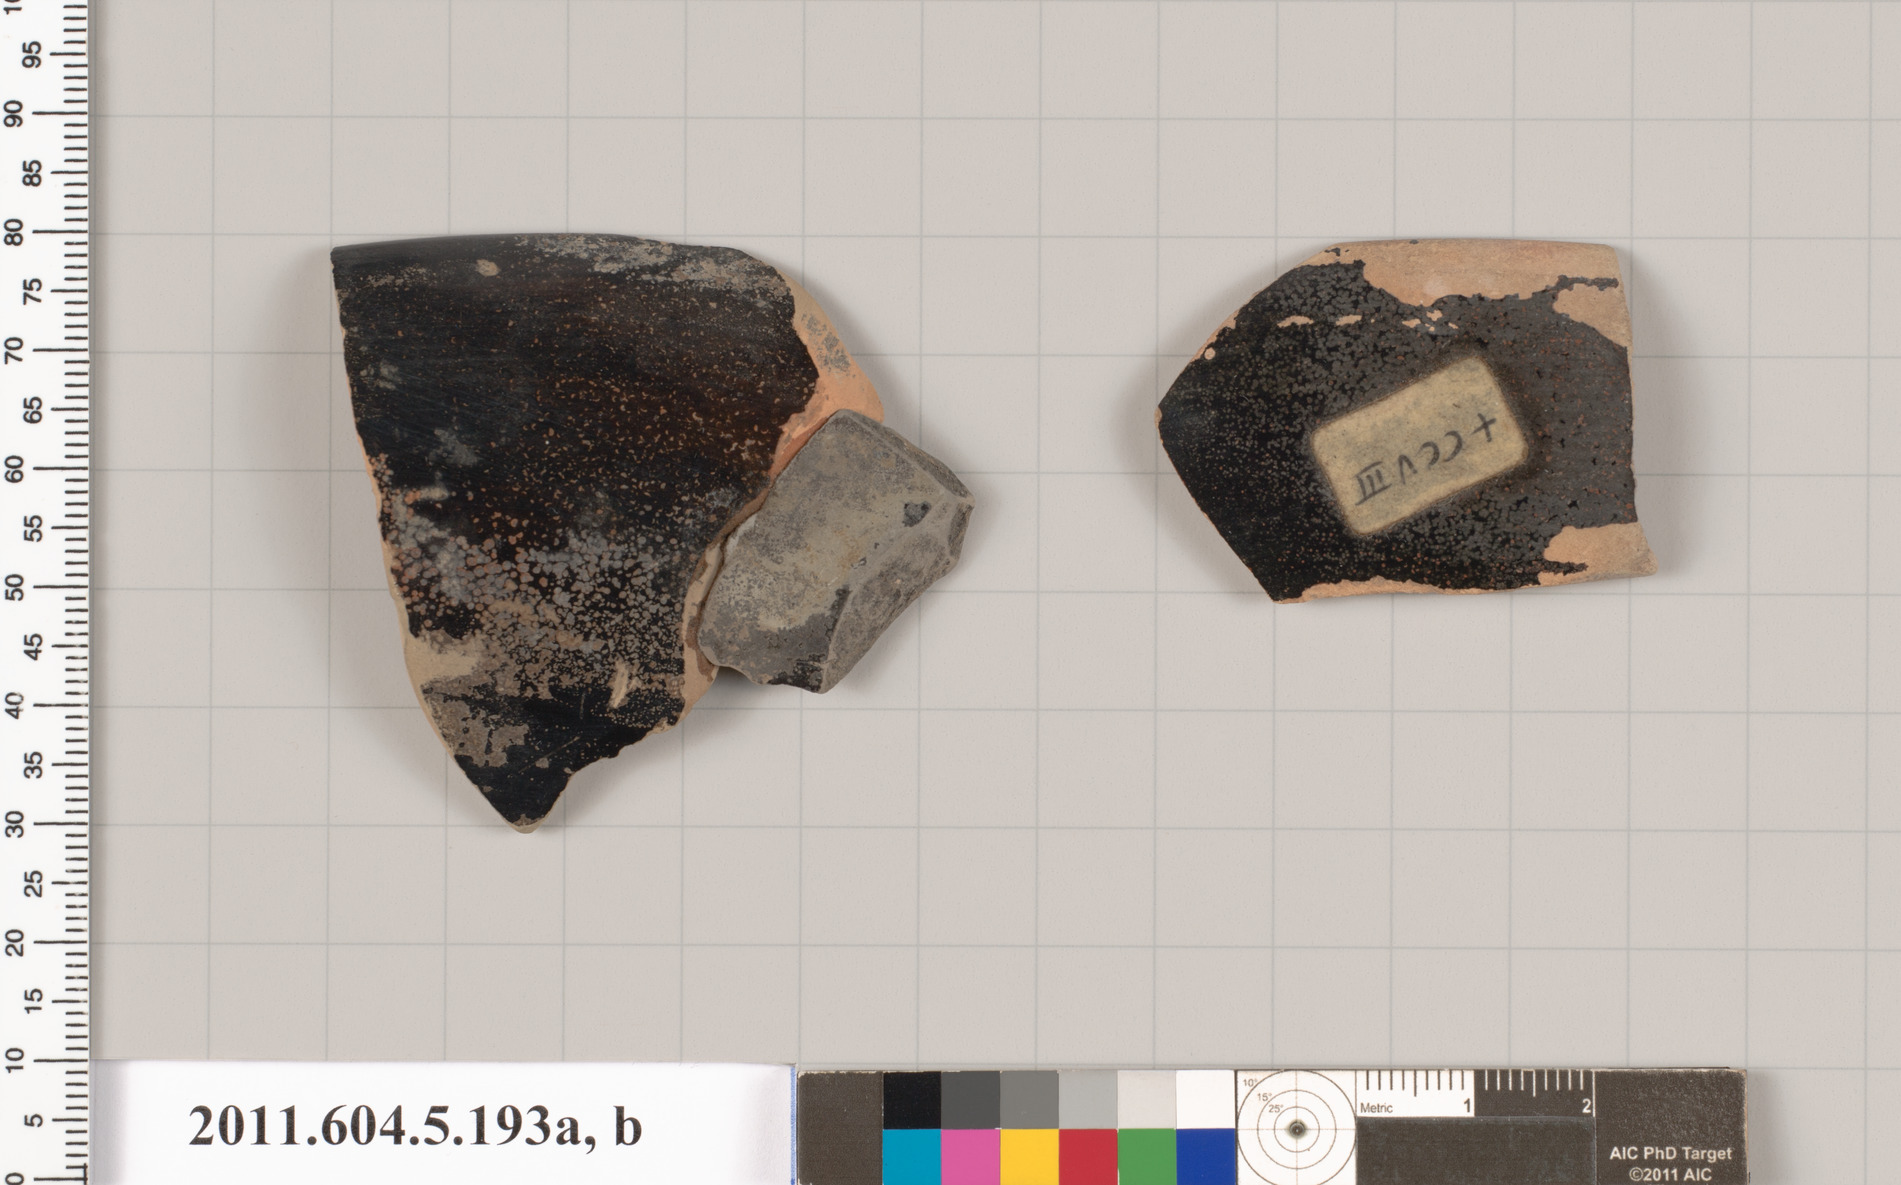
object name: kylix fragment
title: Terracotta rim fragments of kylikes (drinking cups)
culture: greek, attic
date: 600-401 BCE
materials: terracotta